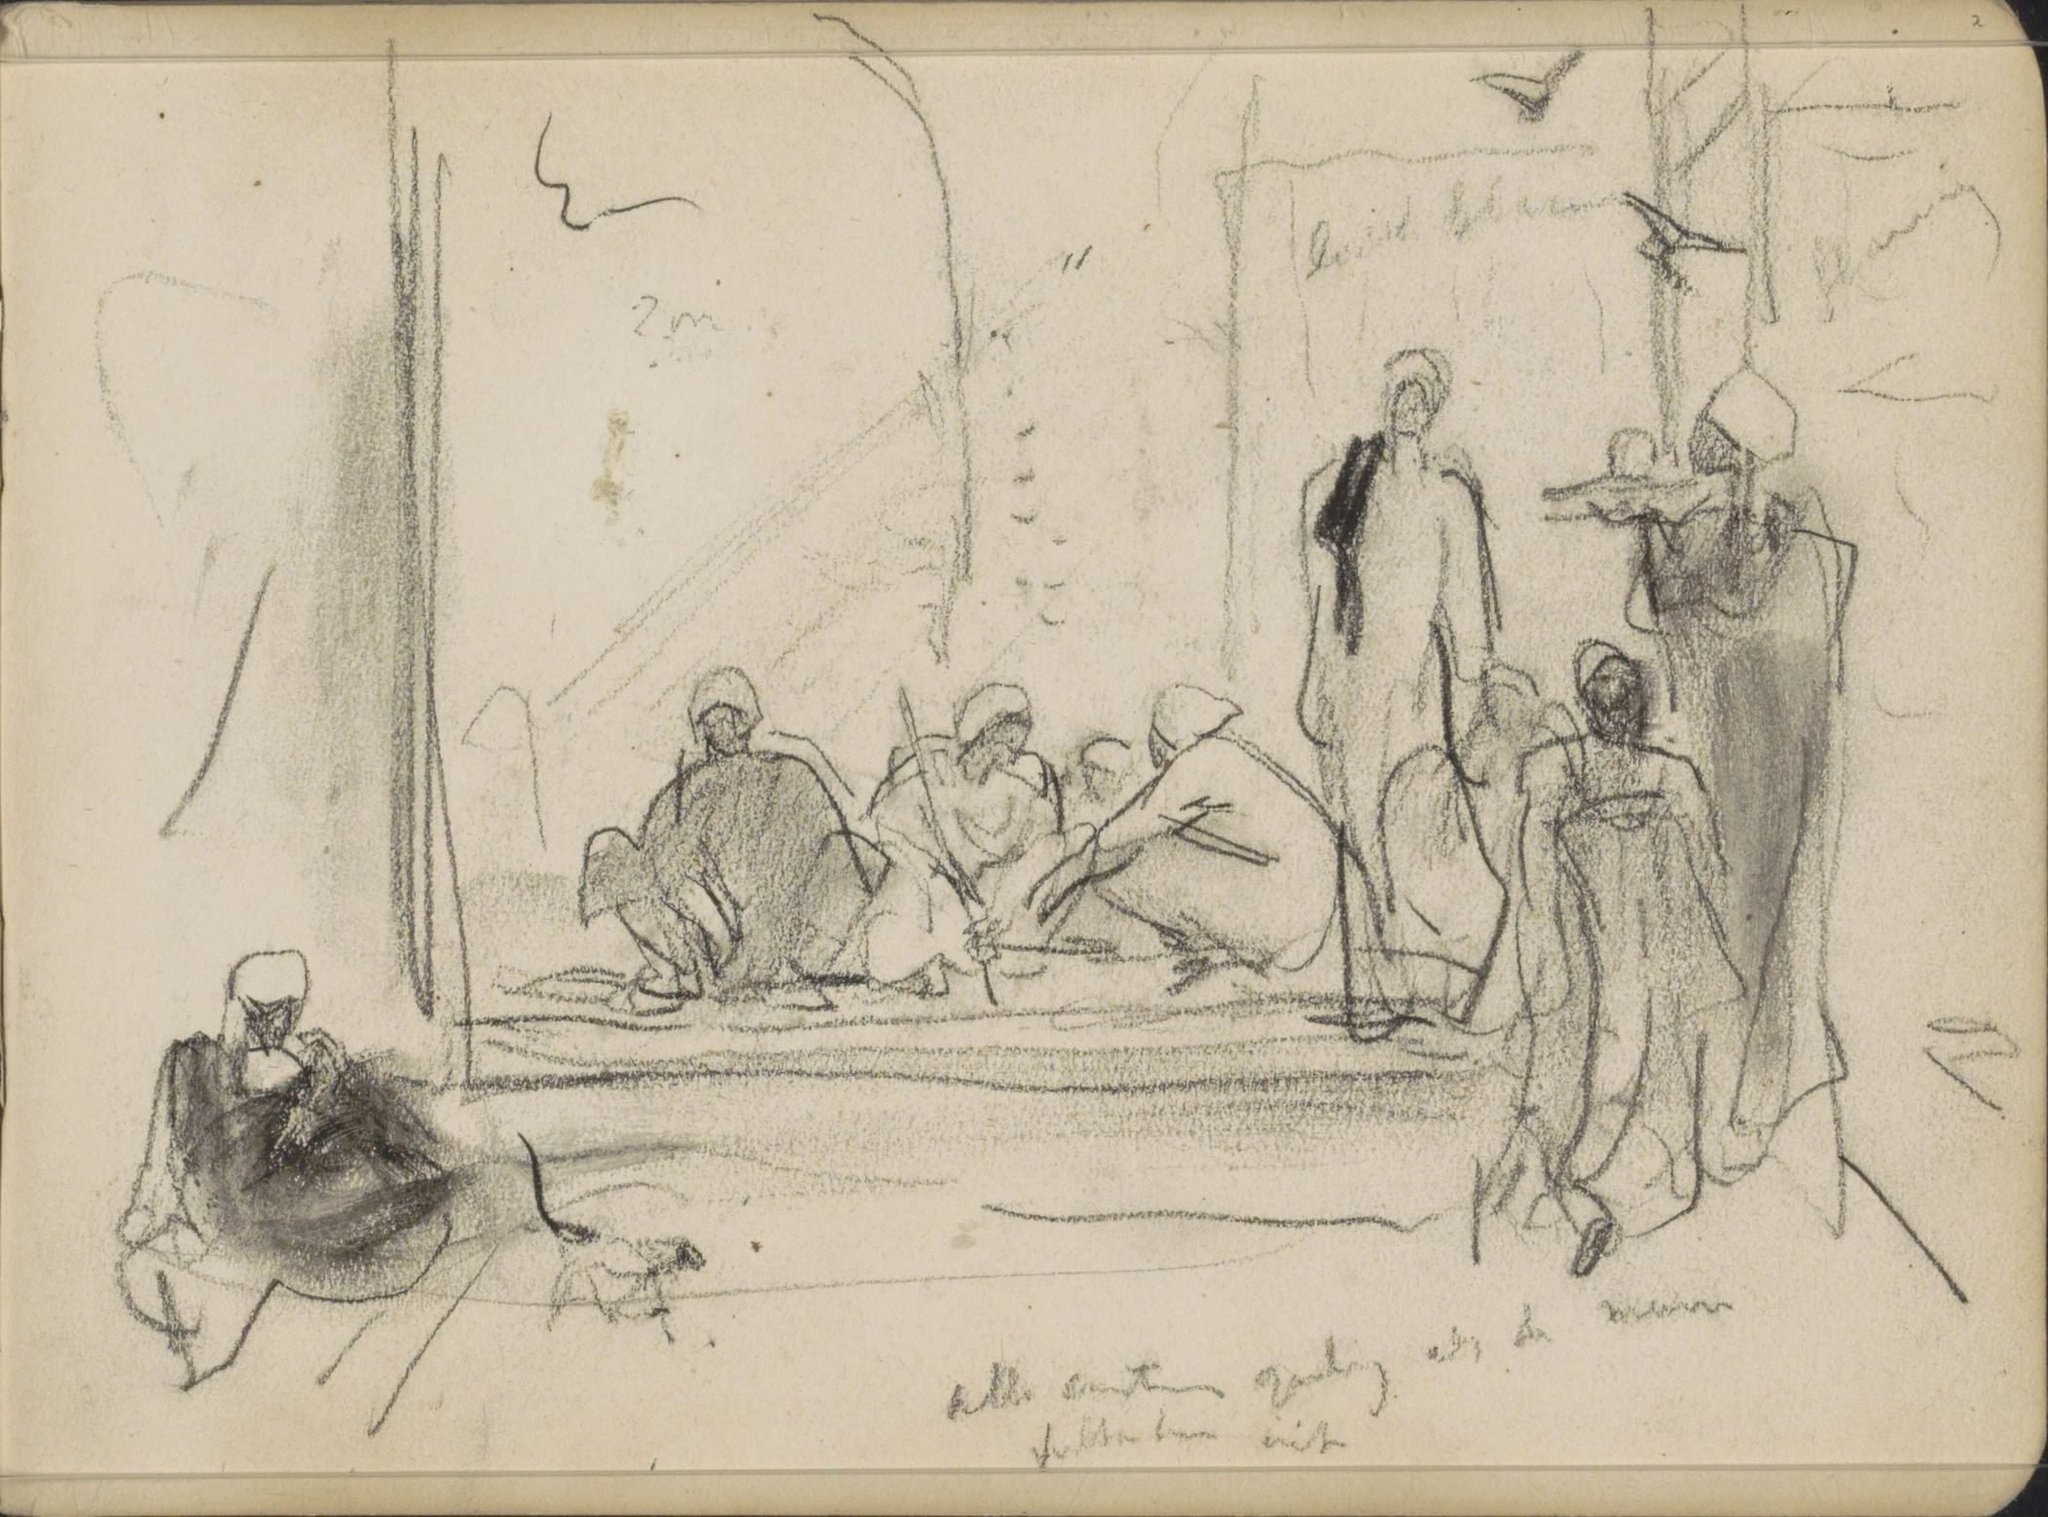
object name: sketchbook leaf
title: Egyptenaren op een straat in Luxor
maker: marius bauer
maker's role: draughtsman, print maker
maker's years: 1867-1932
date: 1919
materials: chalk, paper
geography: luxor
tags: africans, street (+ city(-scape) with figures, staffage)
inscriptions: kleurnotitie, handgeschreven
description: De mannen zitten en staan op een stoep. Eén van hen draagt een dienblad. Pagina 2 uit een schetsboek met 28 bladen.